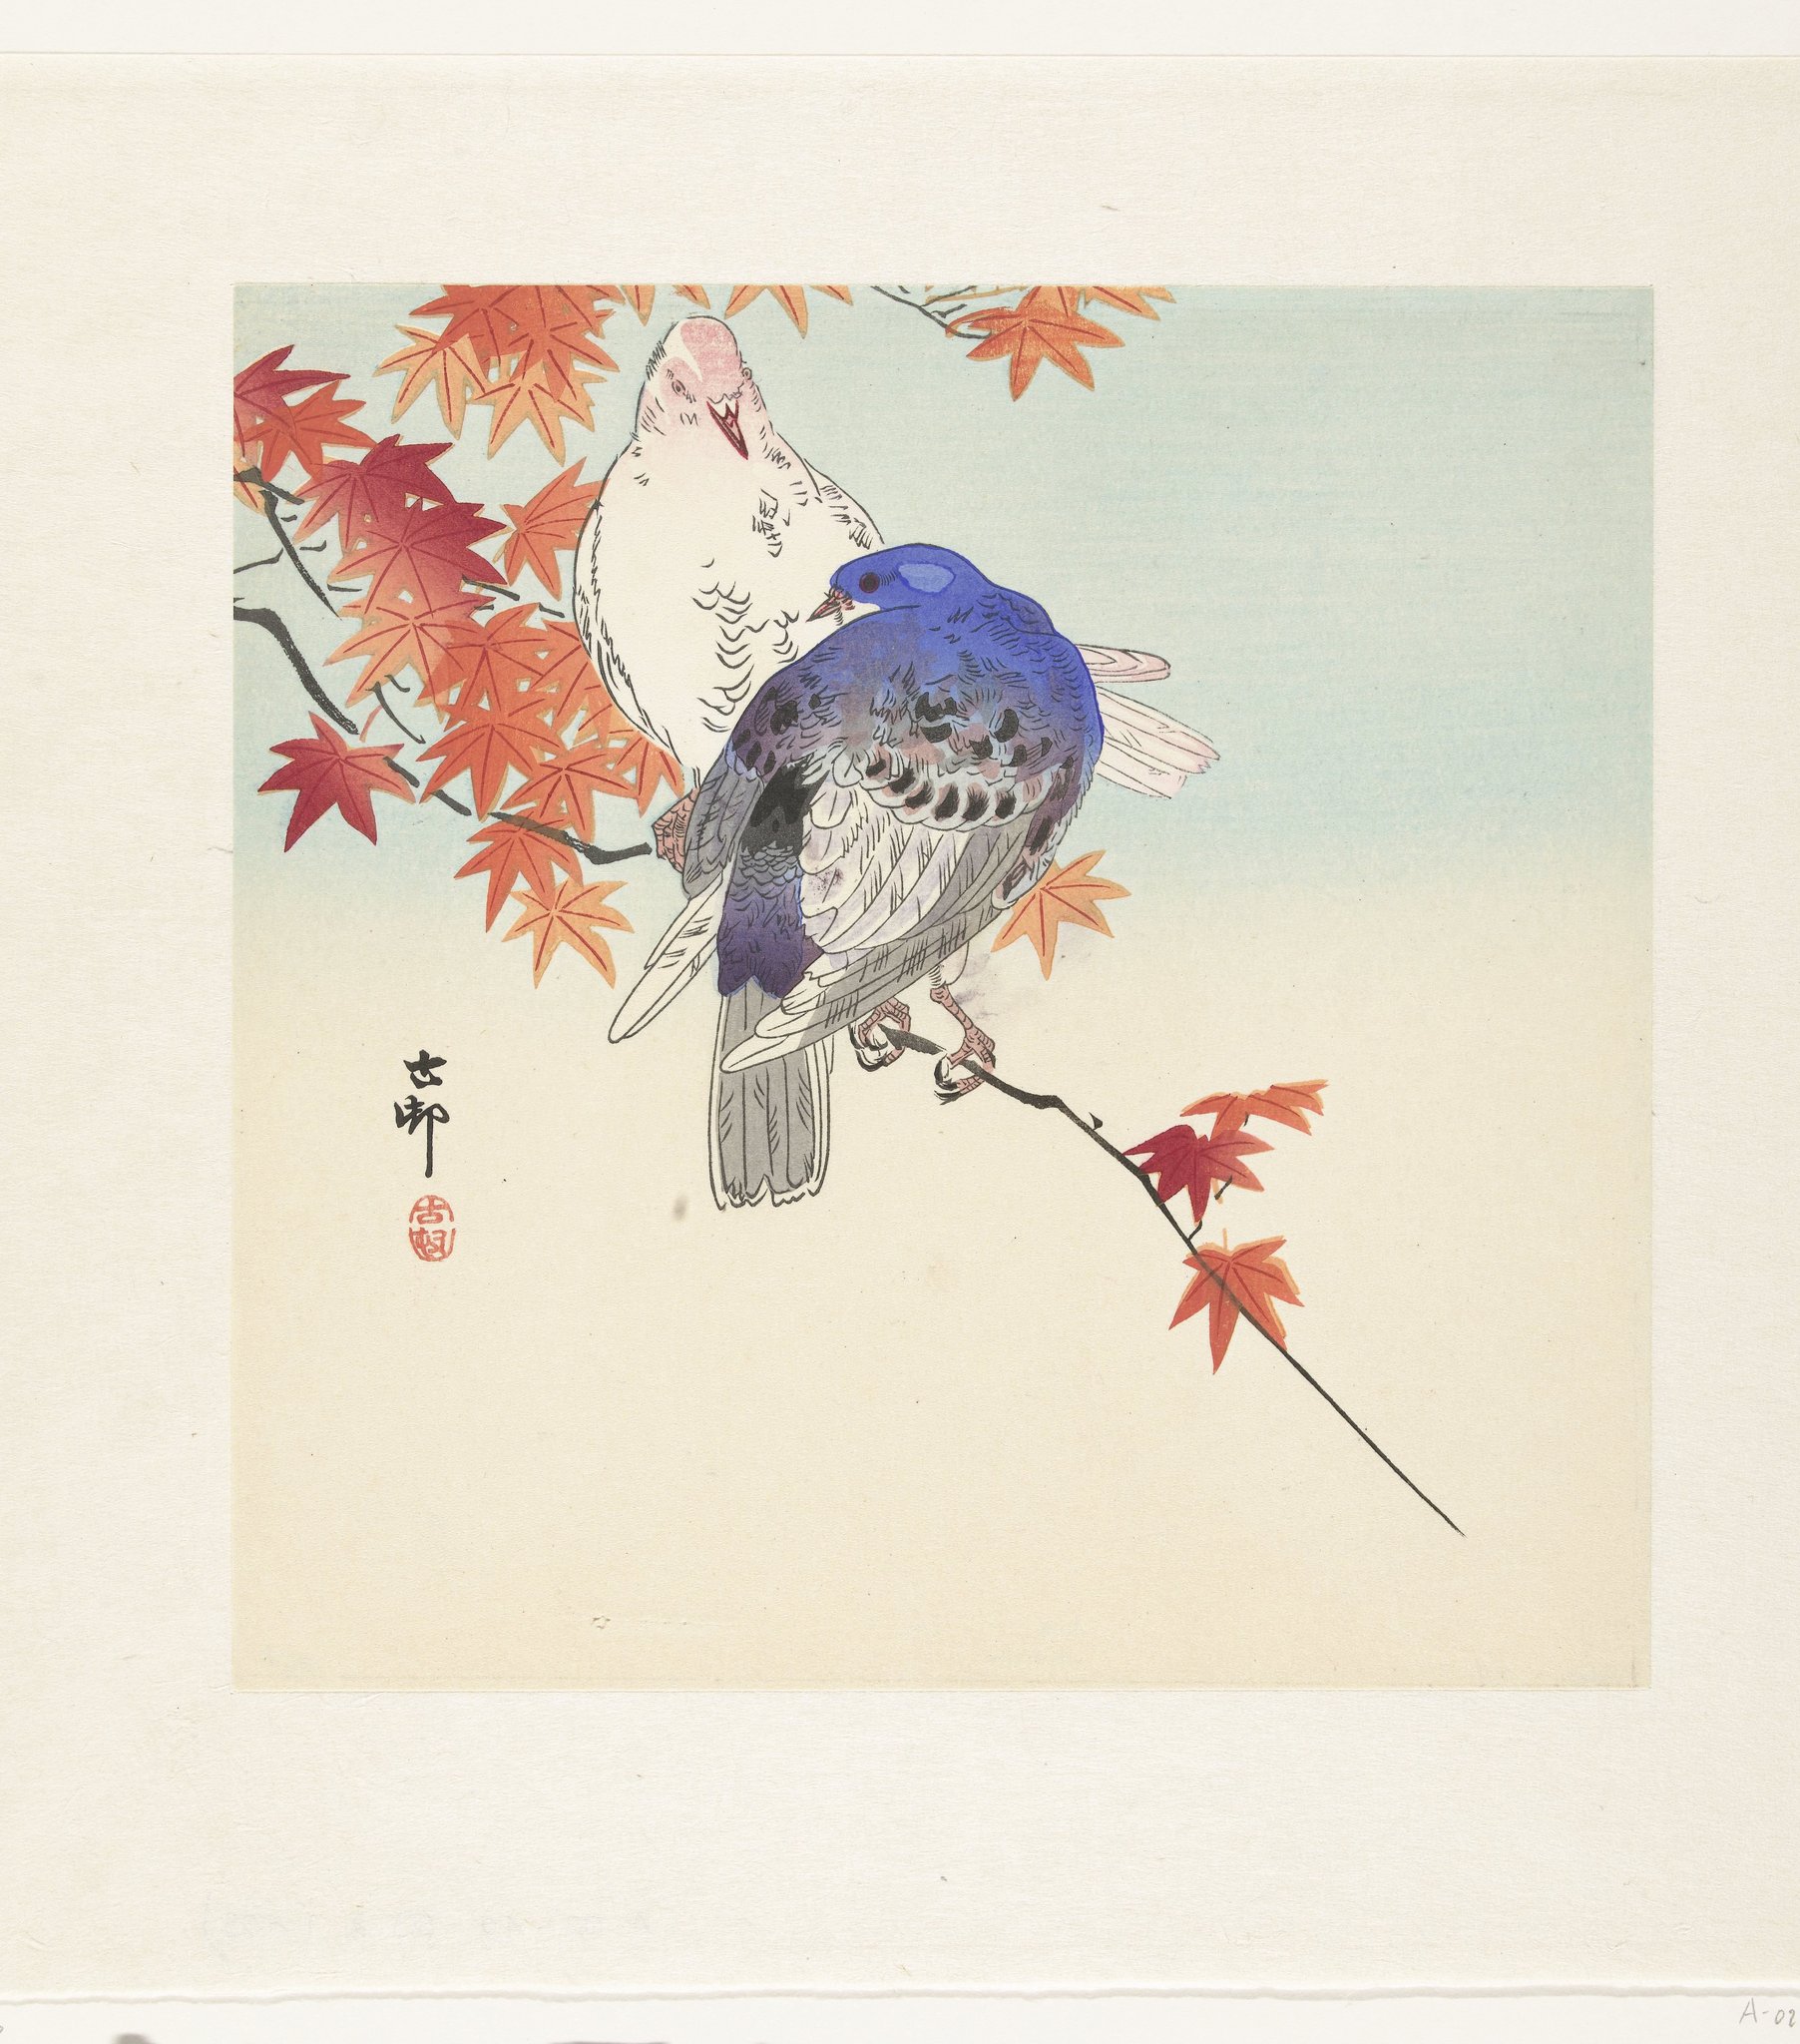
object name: print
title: Twee duiven op herfsttak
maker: ohara koson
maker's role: print maker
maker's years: 1877-1945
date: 1900-1936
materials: paper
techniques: woodcut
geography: japan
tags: plants; vegetation, other birds: dove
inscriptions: collector's mark: Lugt 2228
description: Een witte en een blauwe duif op tak met herfstbladeren